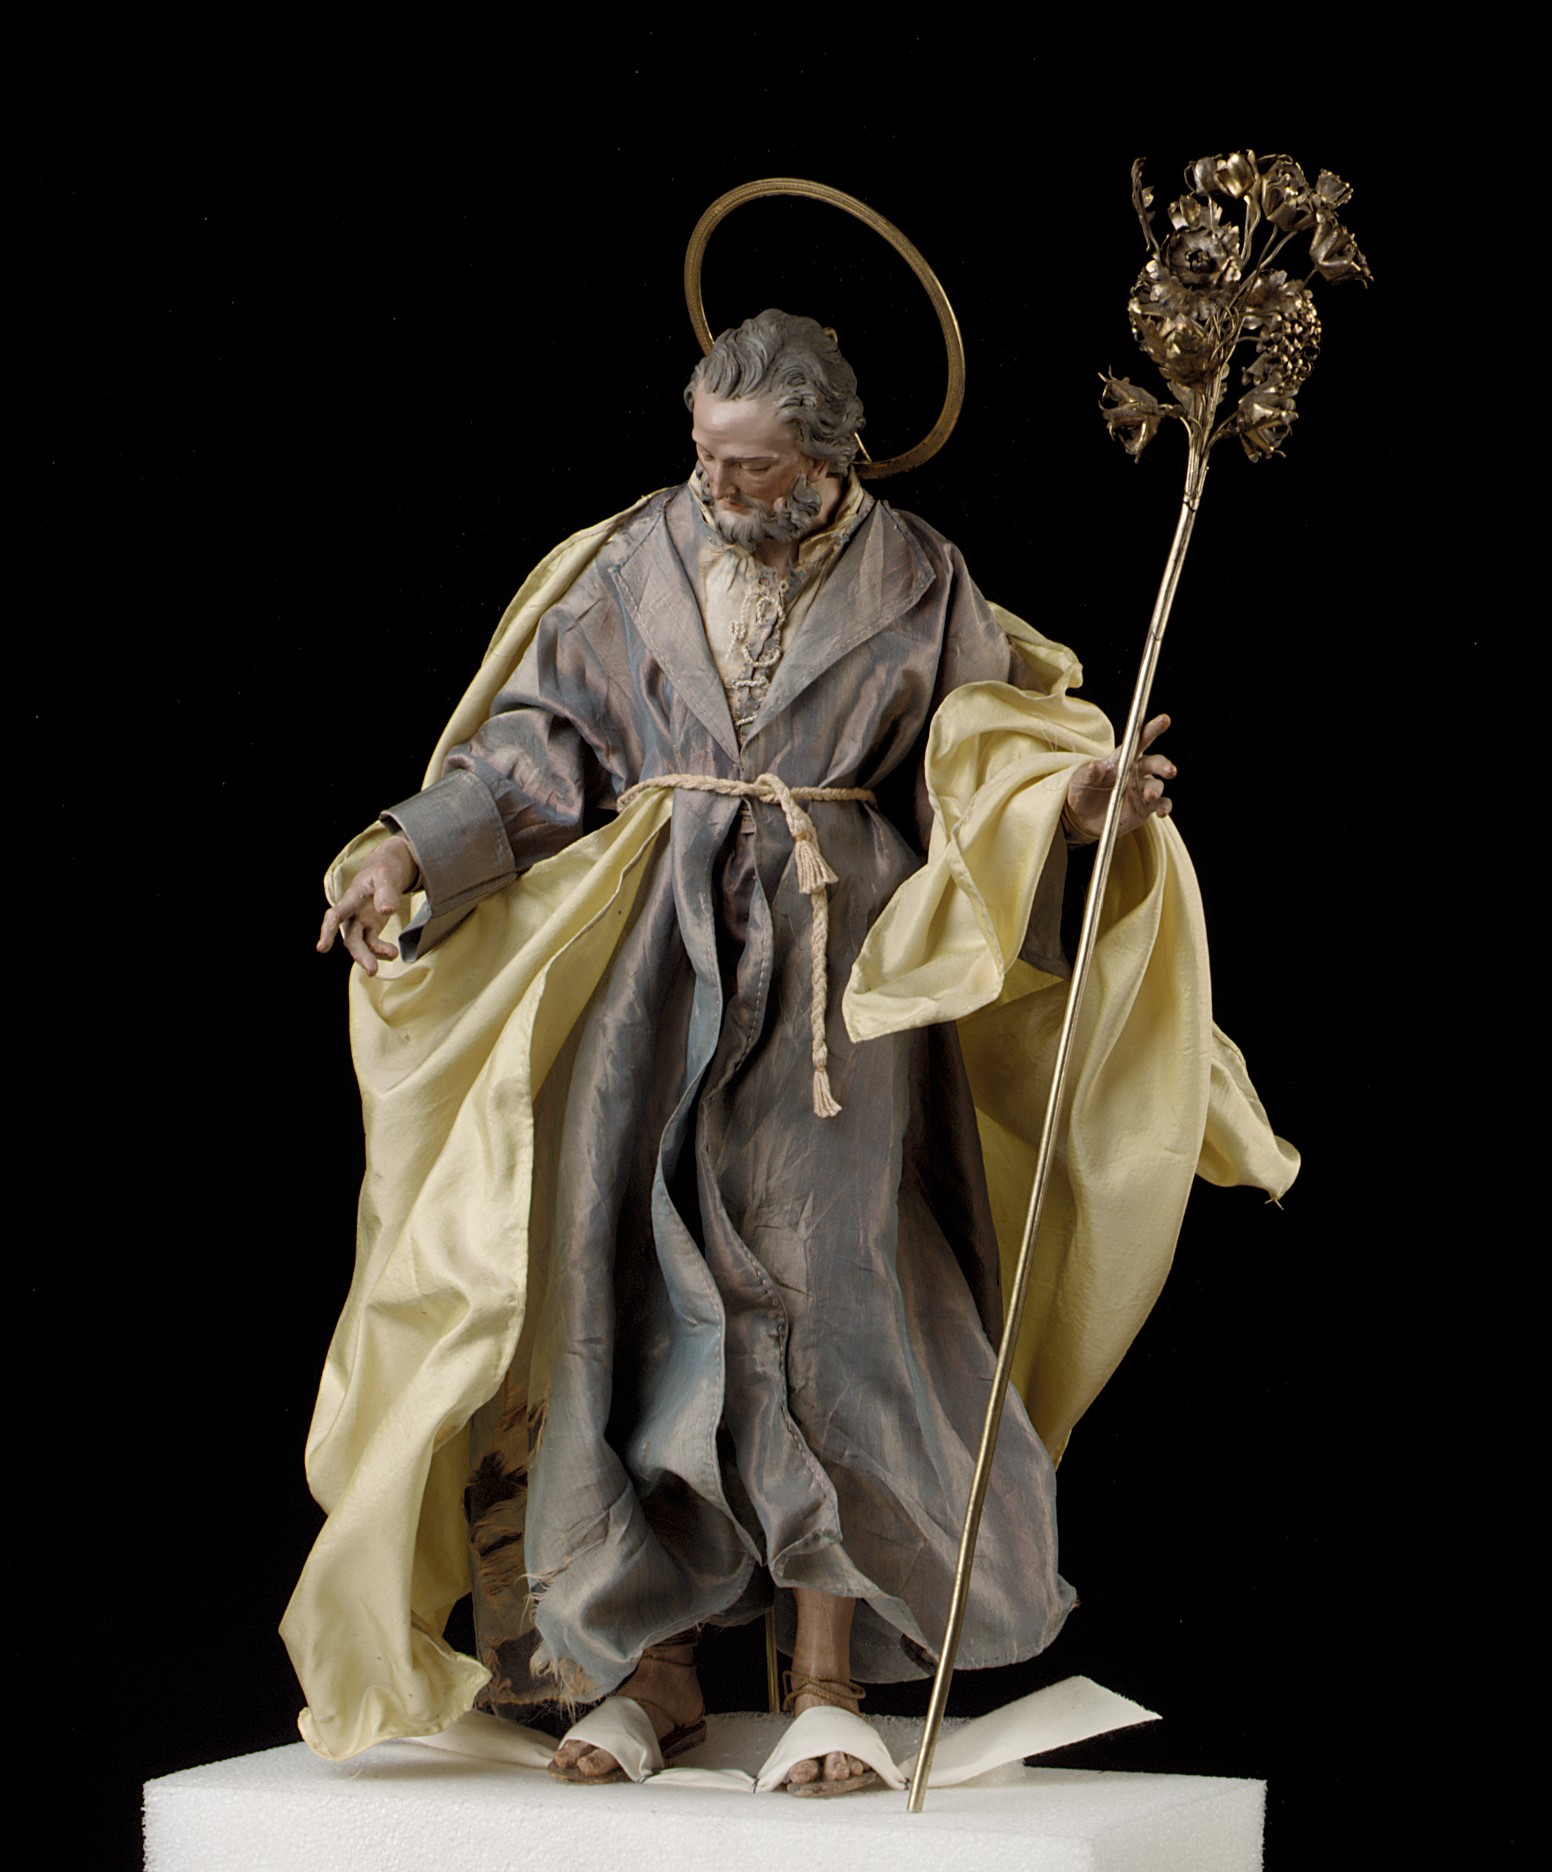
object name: crèche figure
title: St. Joseph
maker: salvatore di franco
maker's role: maker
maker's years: 1700-1799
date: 1751-1800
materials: silver gilt, terracotta, fiber, metal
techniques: polychrome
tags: men,saints